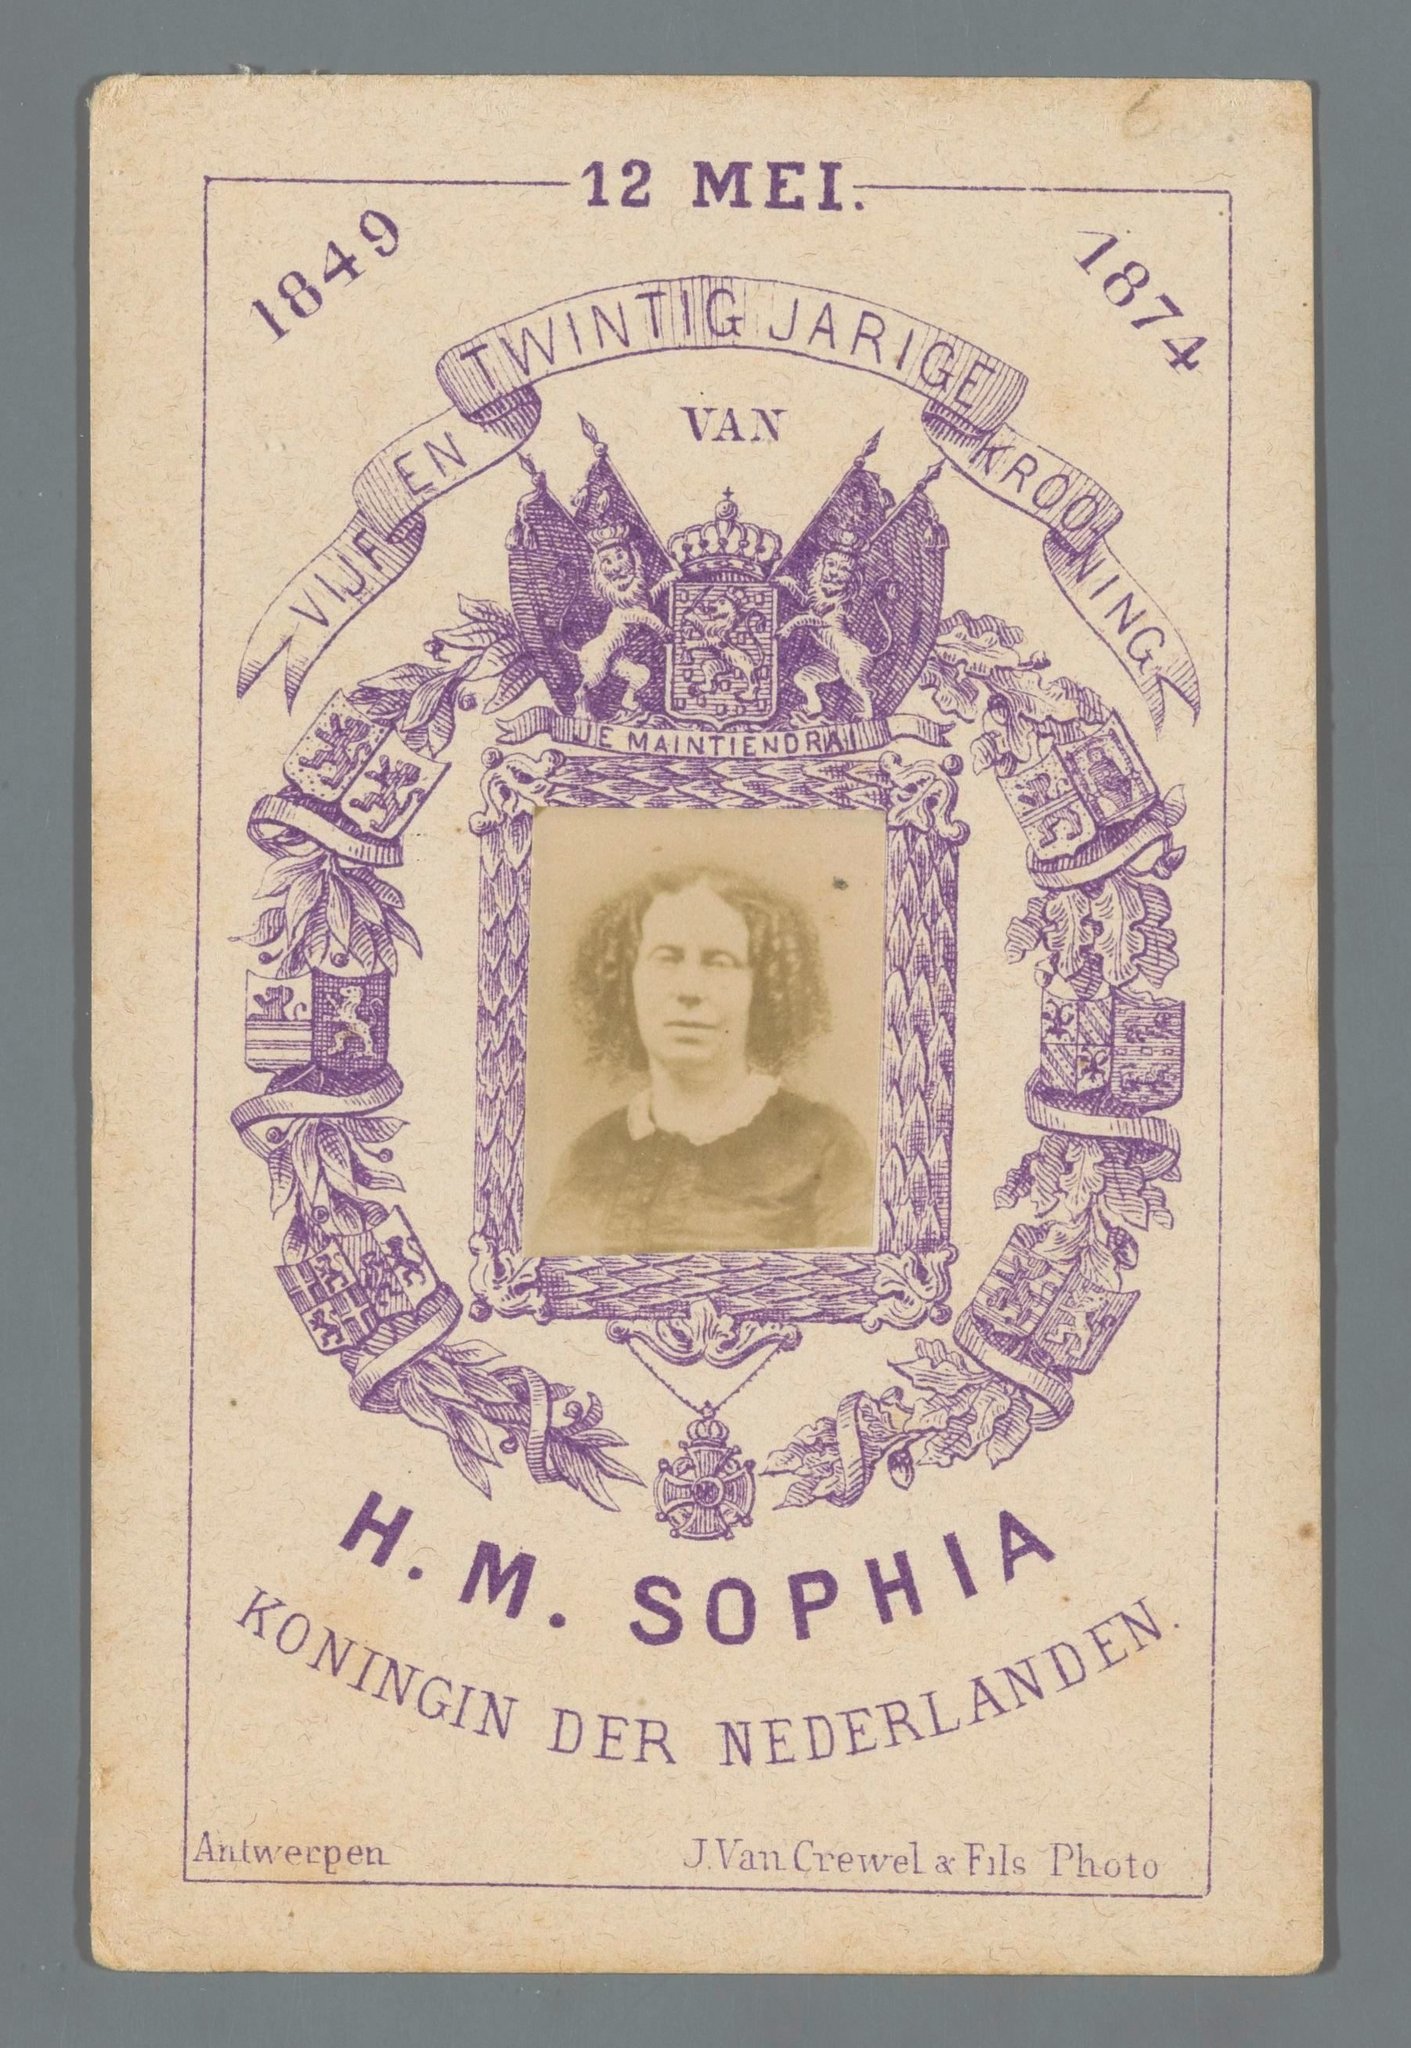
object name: carte de visite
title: Portret van koningin Sophie, uitgegeven ter gelegenheid van het 25-jarig ambtsjubileum in 1874 van Willem III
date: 1874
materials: cardboard, paper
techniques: albumen print, lithograph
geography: antwerp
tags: brussels, willem iii (koning der nederlanden), the hague, sophia frederika mathilda van württemberg, historical persons - bb - woman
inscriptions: annotation: ‘1849 // 12 MEI // 1874 // VIJF EN TWINTIG JARIGE KROONING // VAN // Z.M. WILLEM III // KONING DER NEDERLANDEN // Antwerpen // J. Van Crewel & Fils Photo’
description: Portret van koningin Sophie, in een lithografische randversiering.